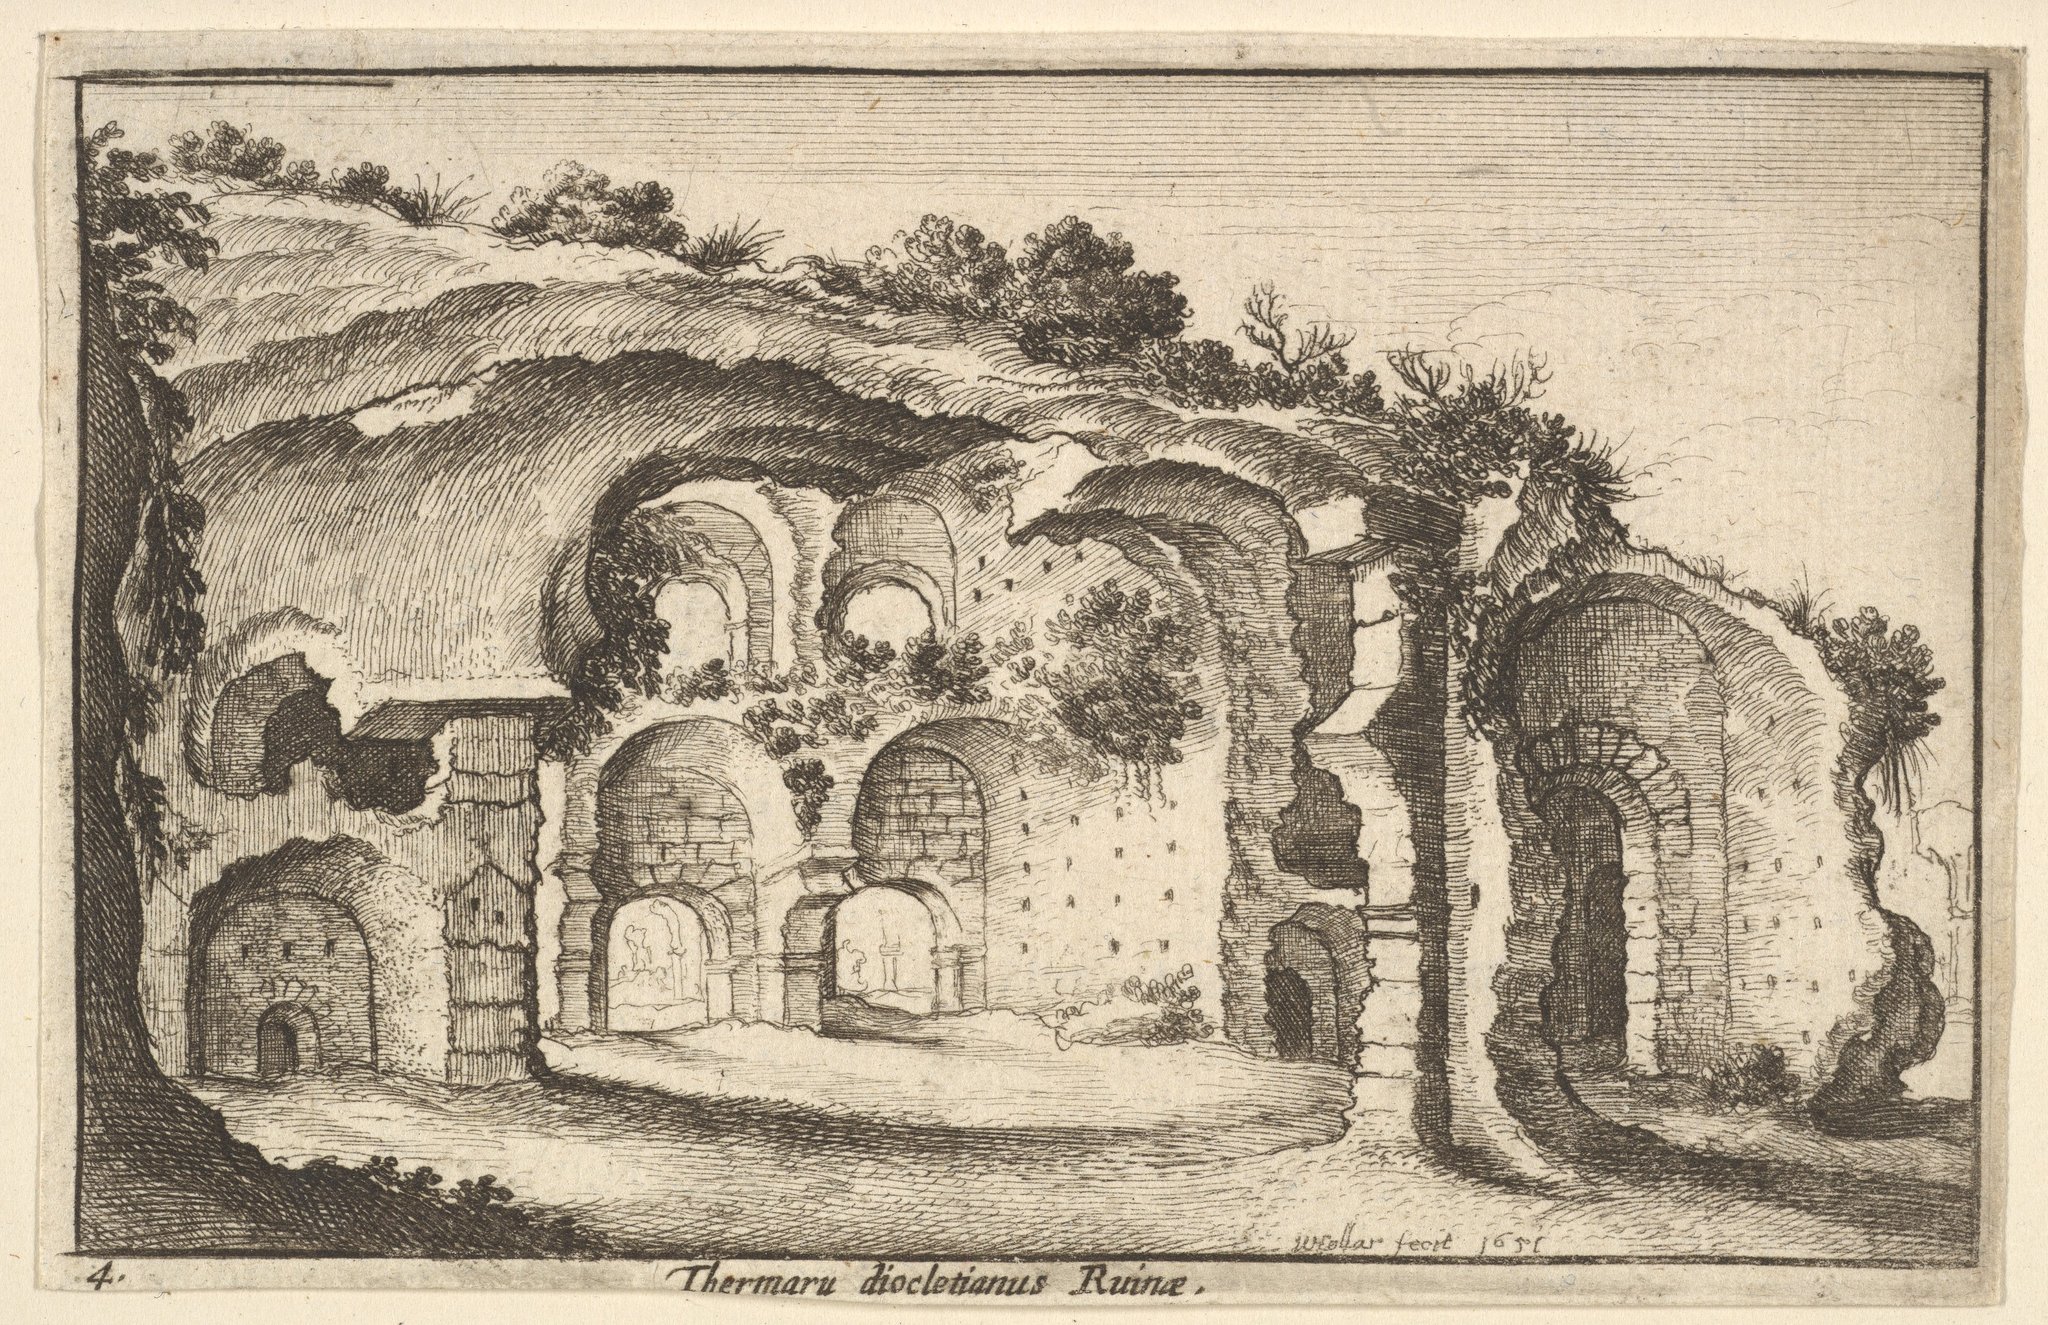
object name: print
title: Thermaru diocletiani Ruinae (Baths of Diocletian), from "Roman Ruins"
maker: wenceslaus hollar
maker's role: artist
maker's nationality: bohemian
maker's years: 1607-1677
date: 1651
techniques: etching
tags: ruins,plants